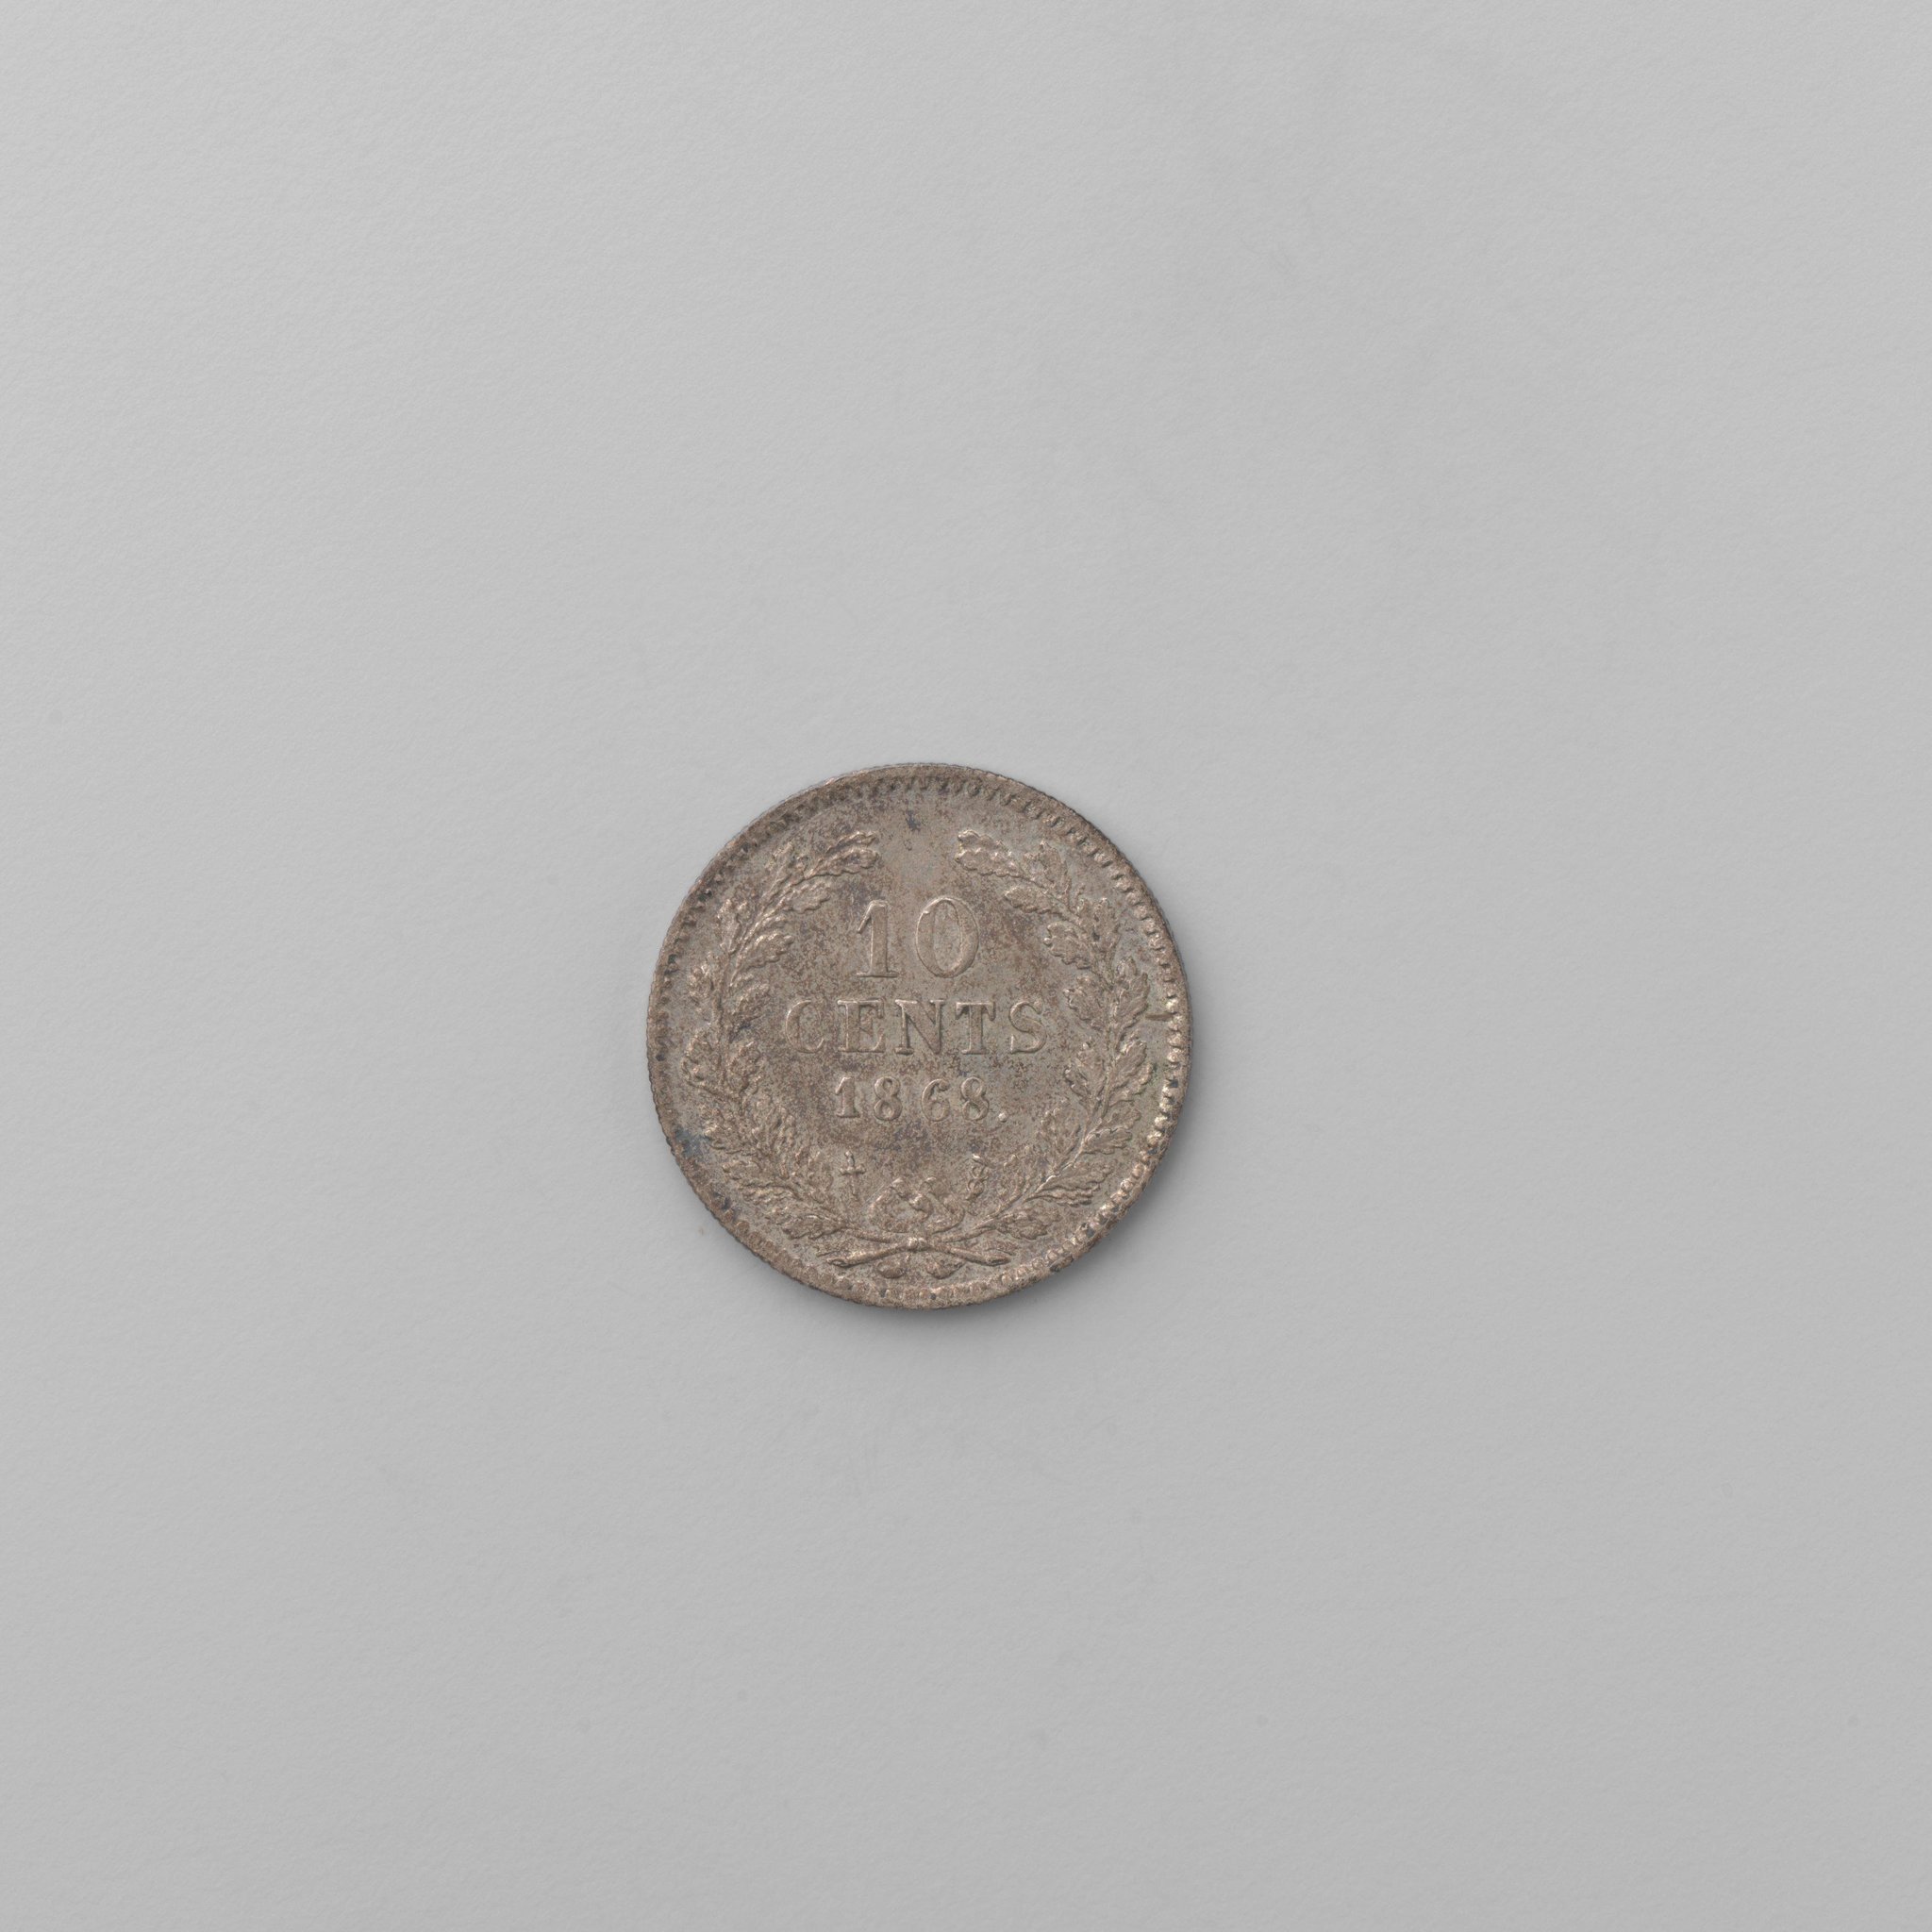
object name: coin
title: Nederland, 10 cent, 1868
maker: willem iii (koning der nederlanden)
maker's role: koning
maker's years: 1817-1890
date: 1868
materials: silver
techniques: striking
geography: utrecht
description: Zilveren munt. Voorzijde: borstbeeld naar rechts. Keerzijde: binnen twee samengebonden eiketakken waarde-aanduiding 10 cents en jaartal. Kartelrand.